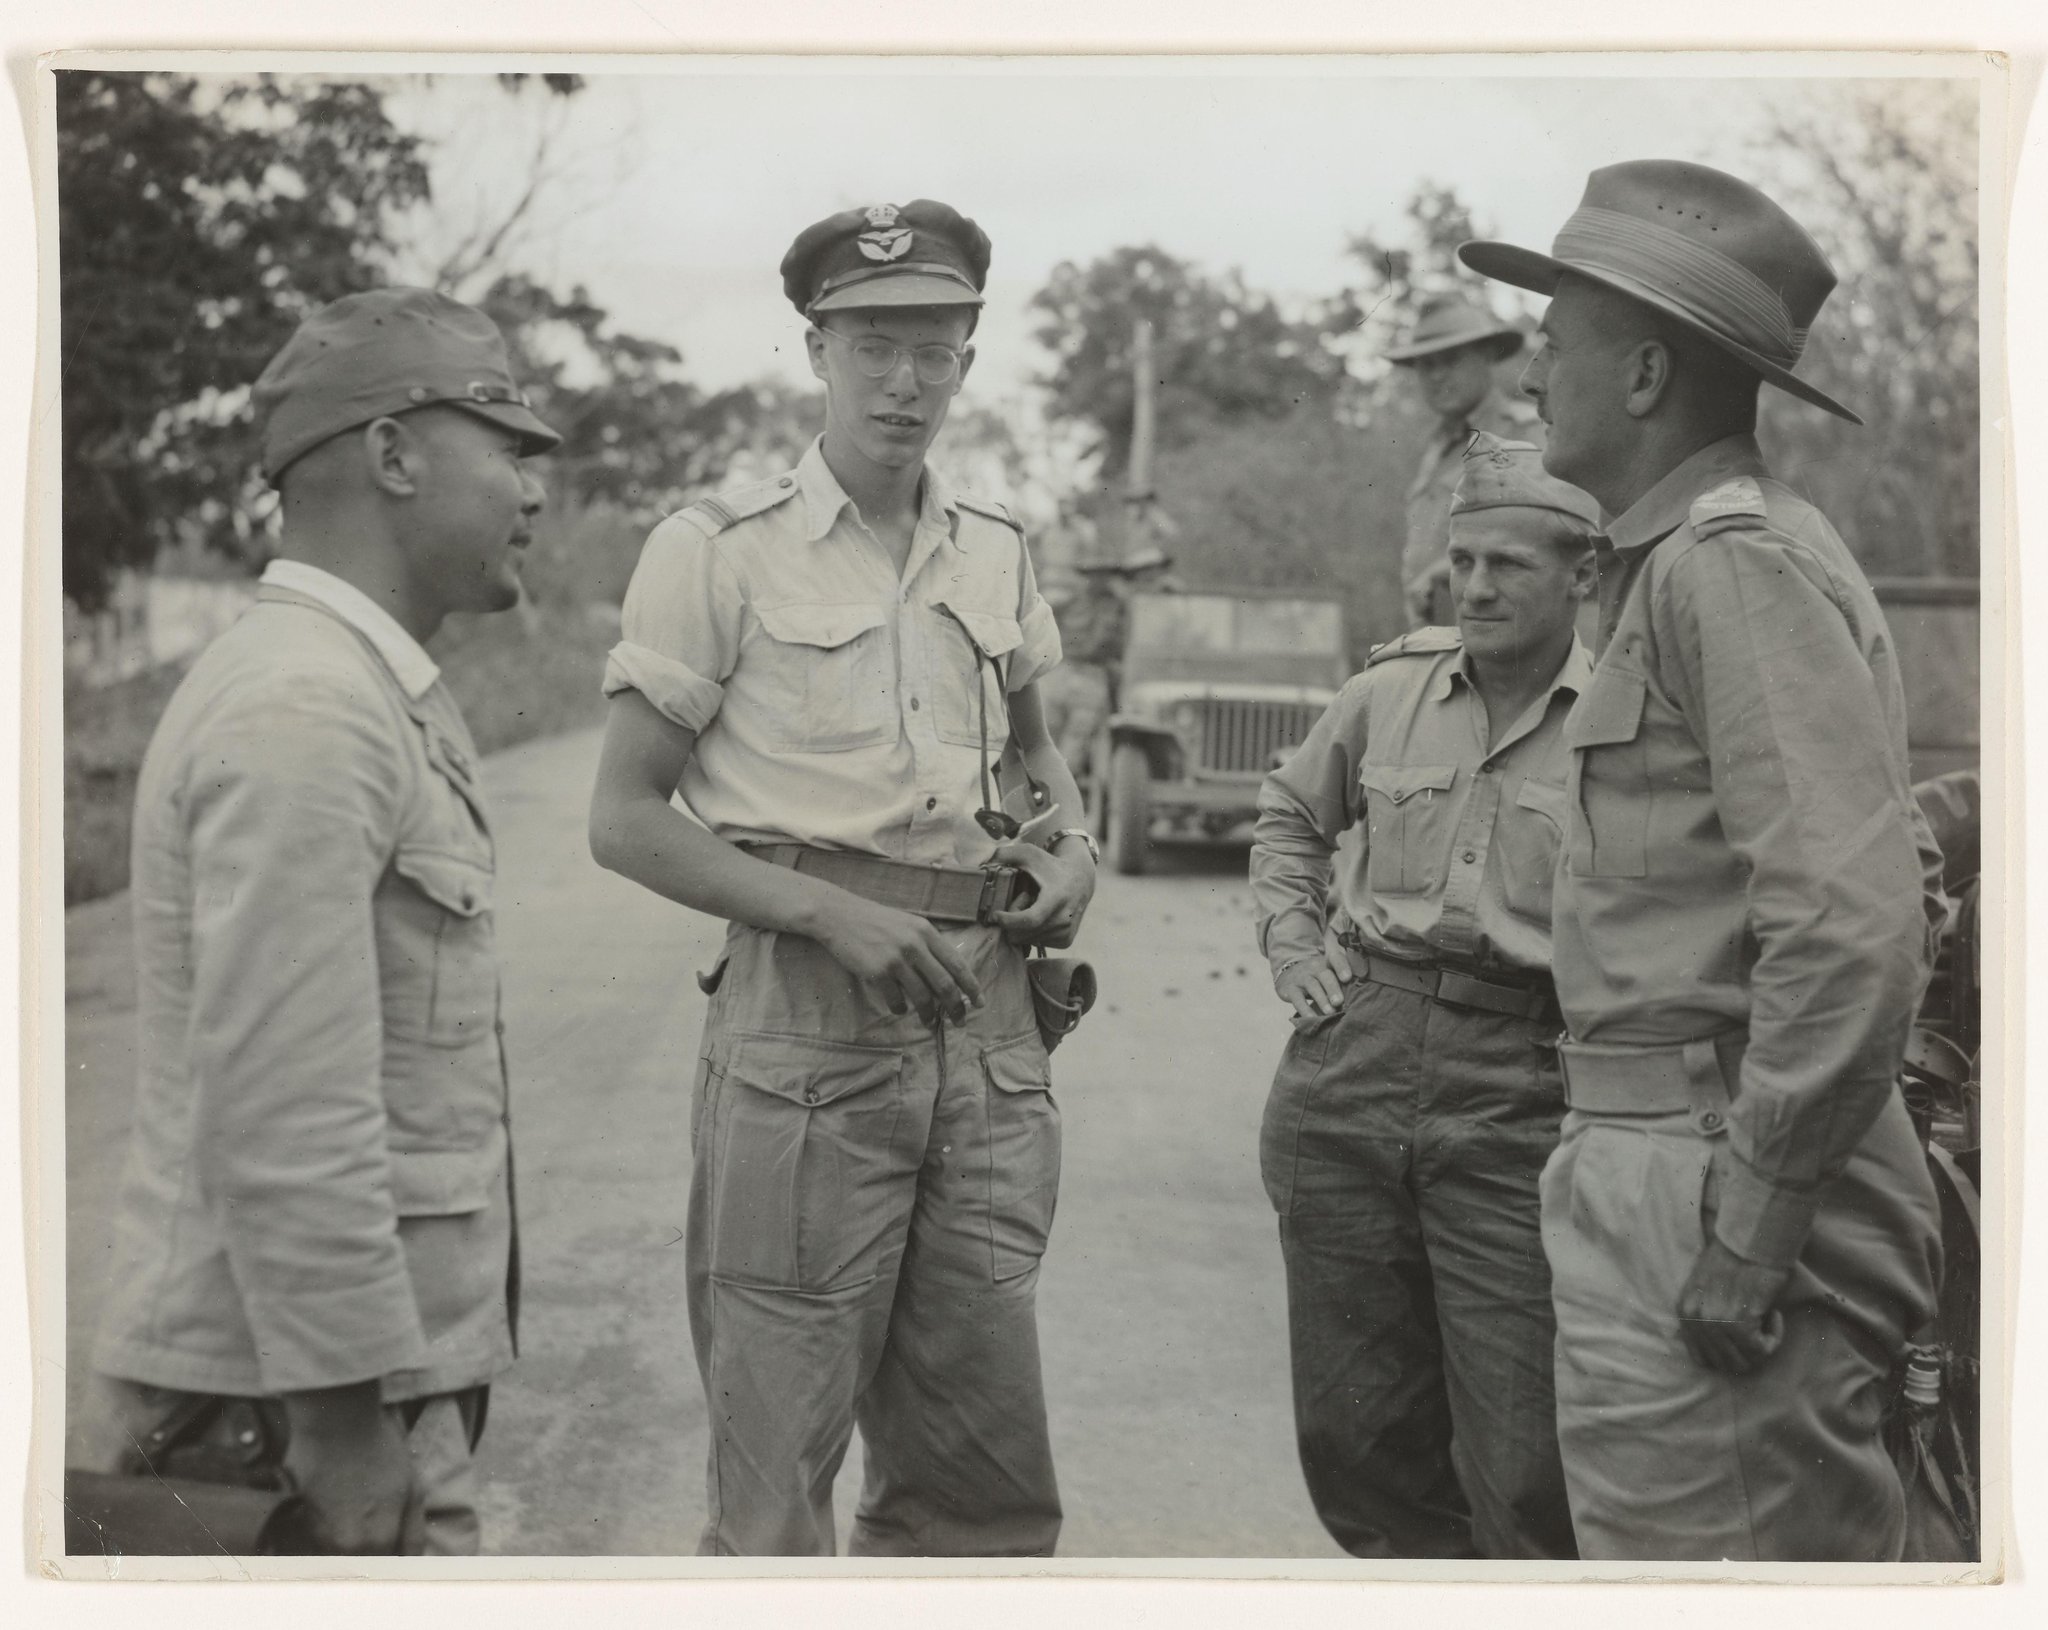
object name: photograph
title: Ondervraging van een Japanse commandant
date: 1946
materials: photographic support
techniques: photography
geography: dutch east indies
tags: dutch east indies, the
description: Na de Japanse overgave zijn de geallieerden aangekomen op Timor. Een Japanse commandant wordt ondervraagd door Nederlandse militairen.